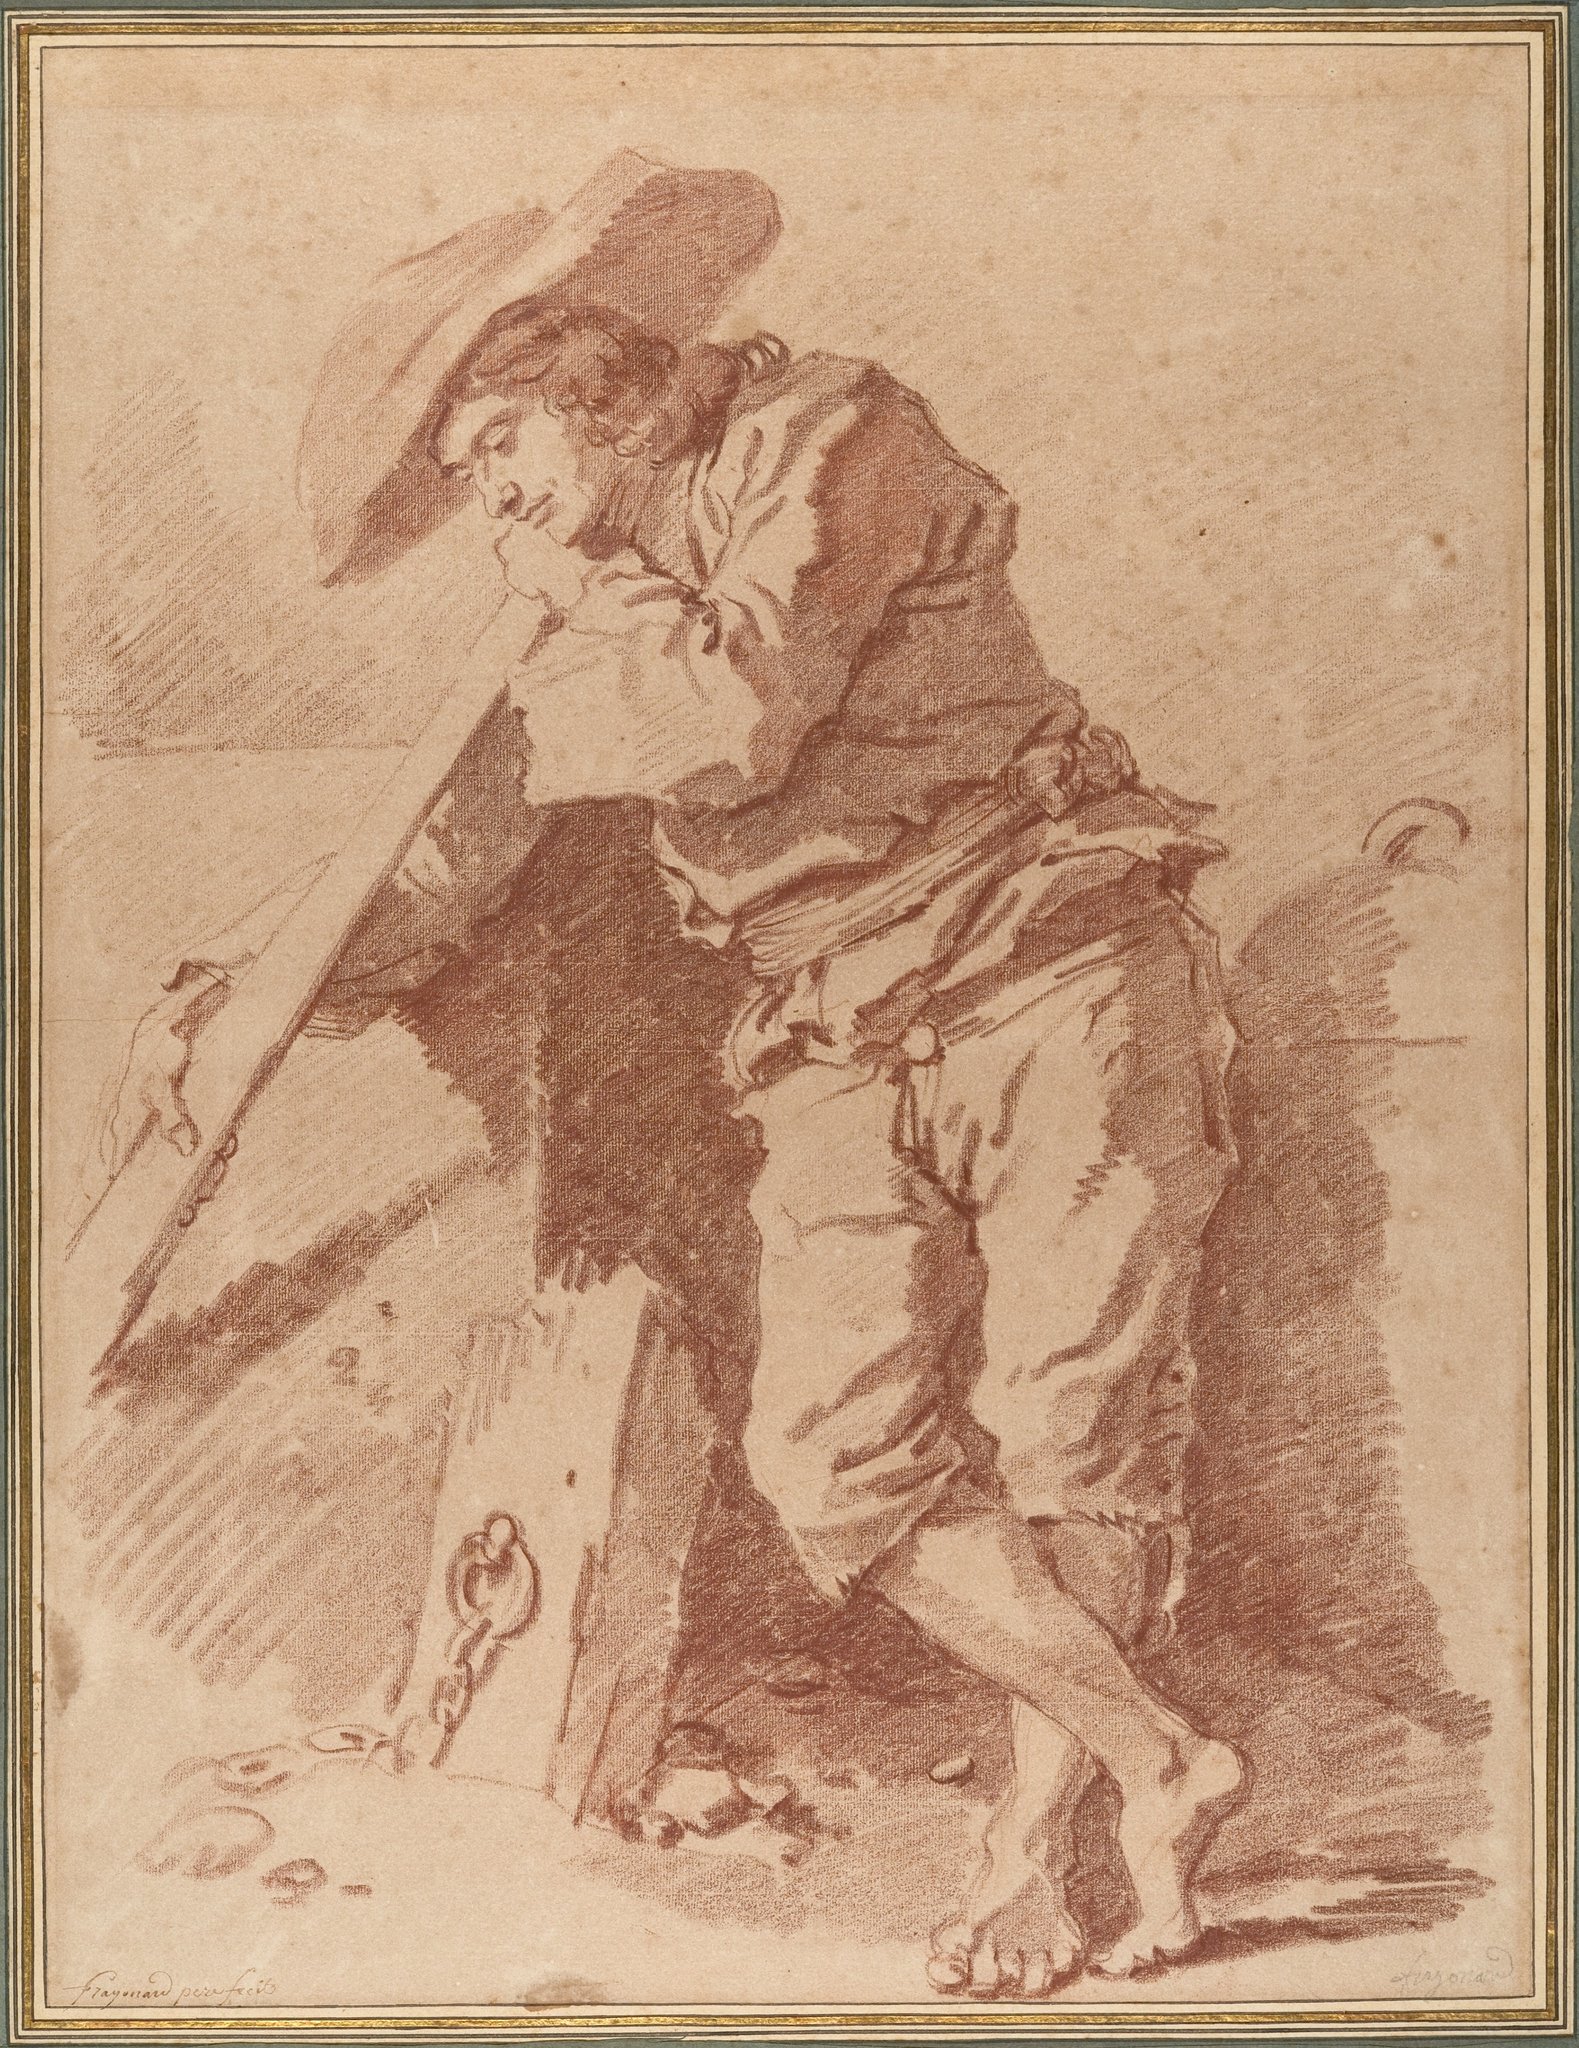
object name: drawing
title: A Fisherman Leaning on an Oar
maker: jean honoré fragonard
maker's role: artist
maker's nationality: french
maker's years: 1732-1806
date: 1774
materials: chalk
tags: men